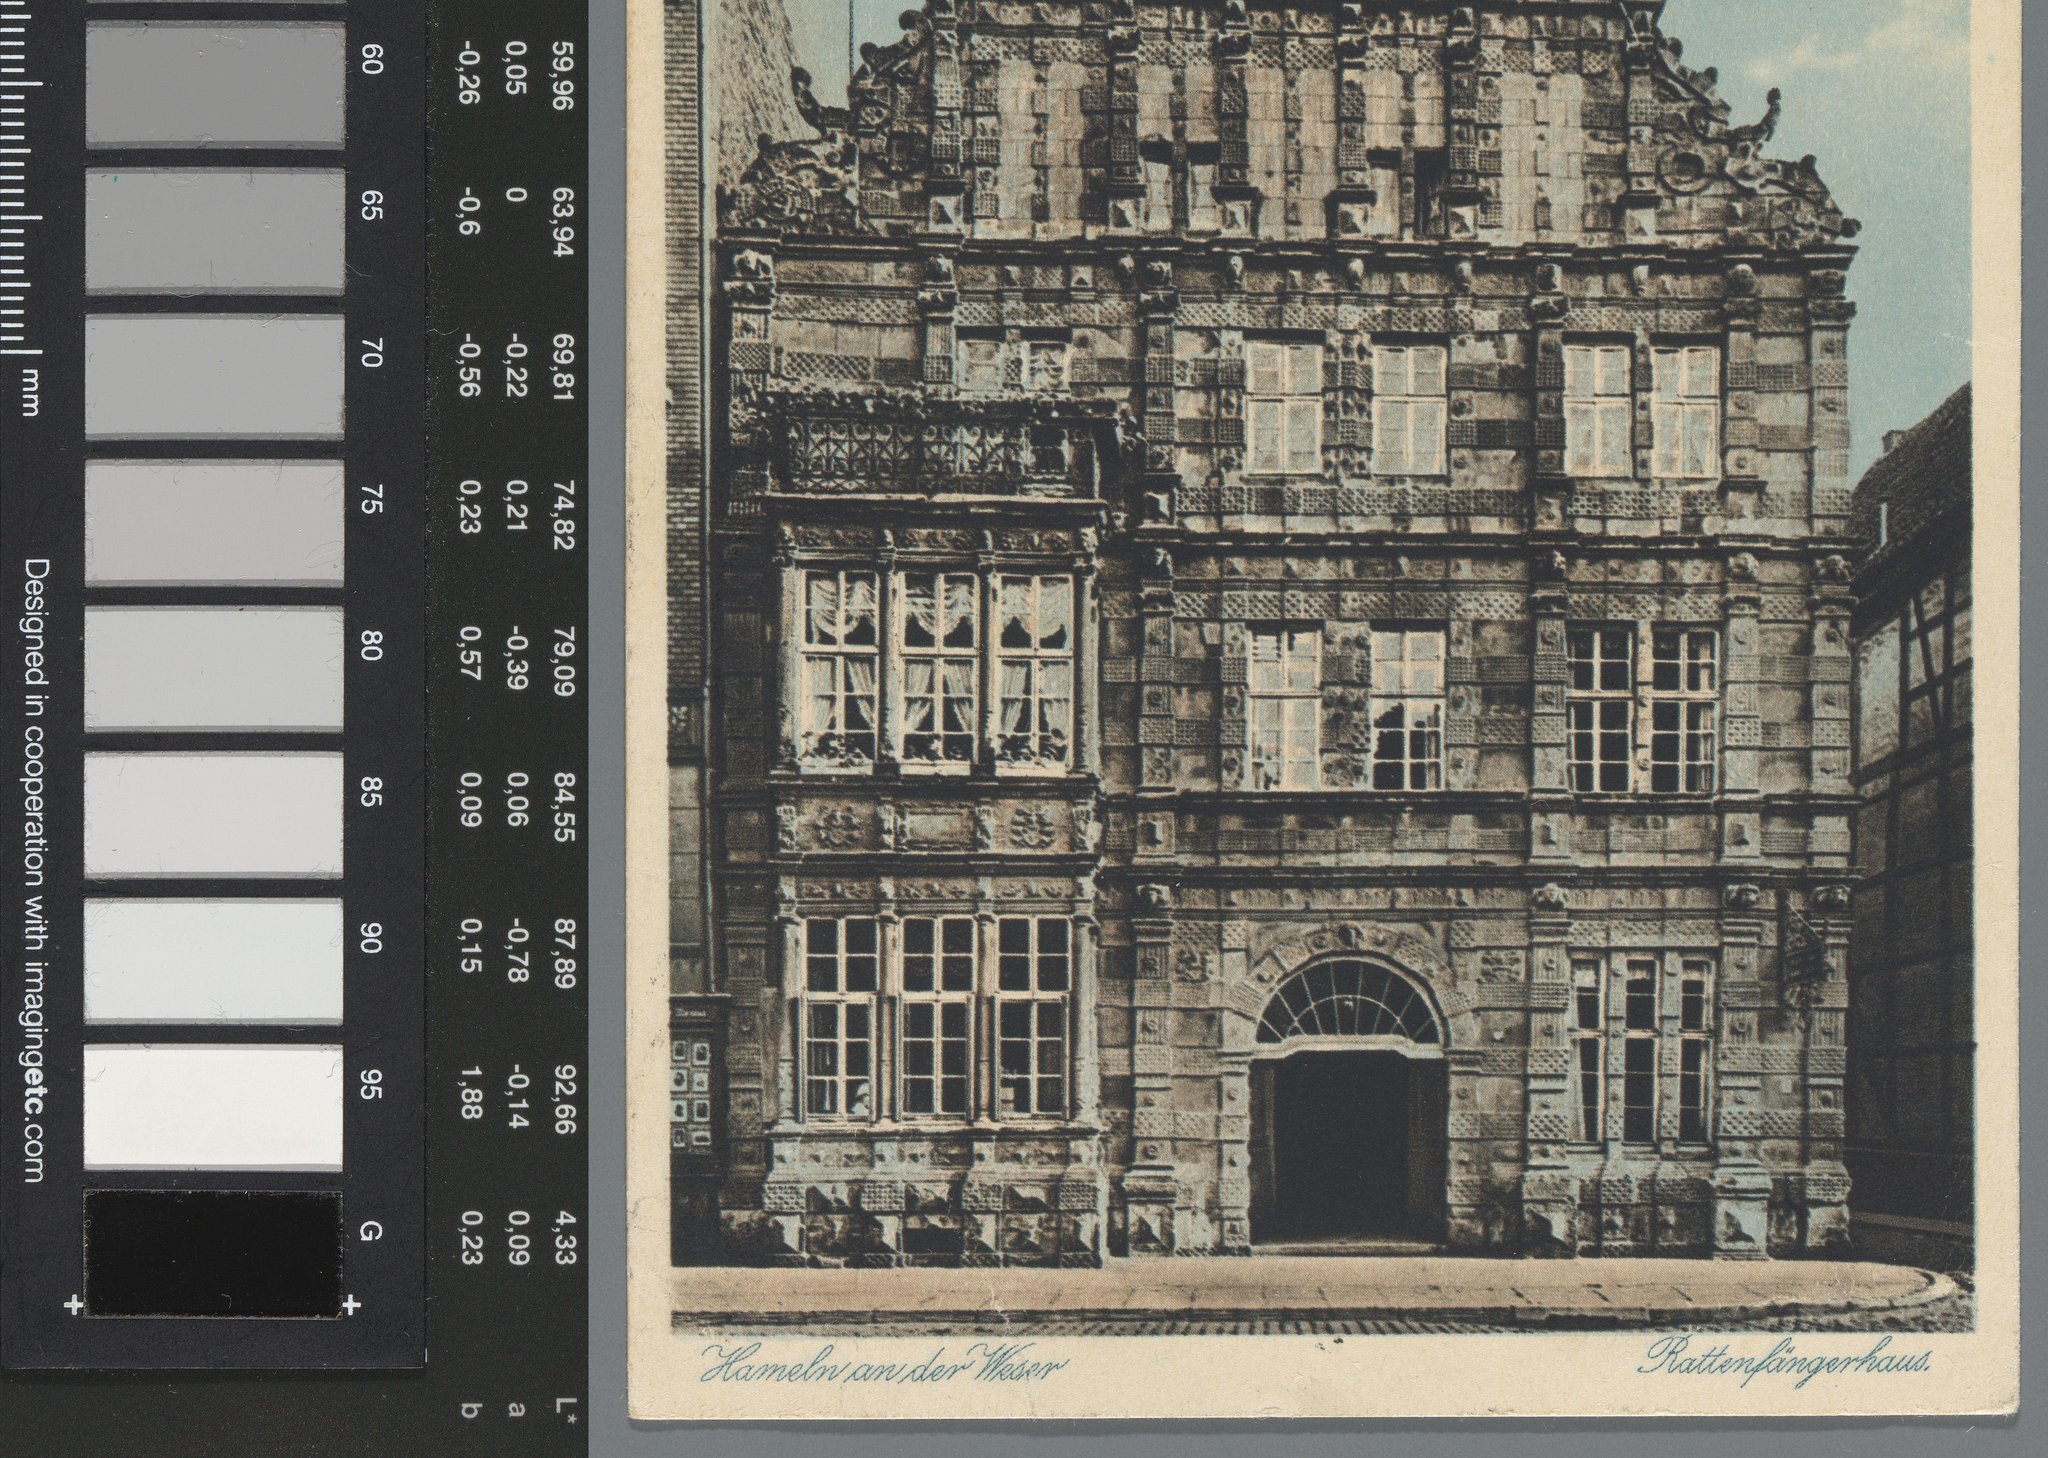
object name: postcard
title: Rottenfangerhaus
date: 1920-1950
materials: photographic support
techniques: rotogravure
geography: germany